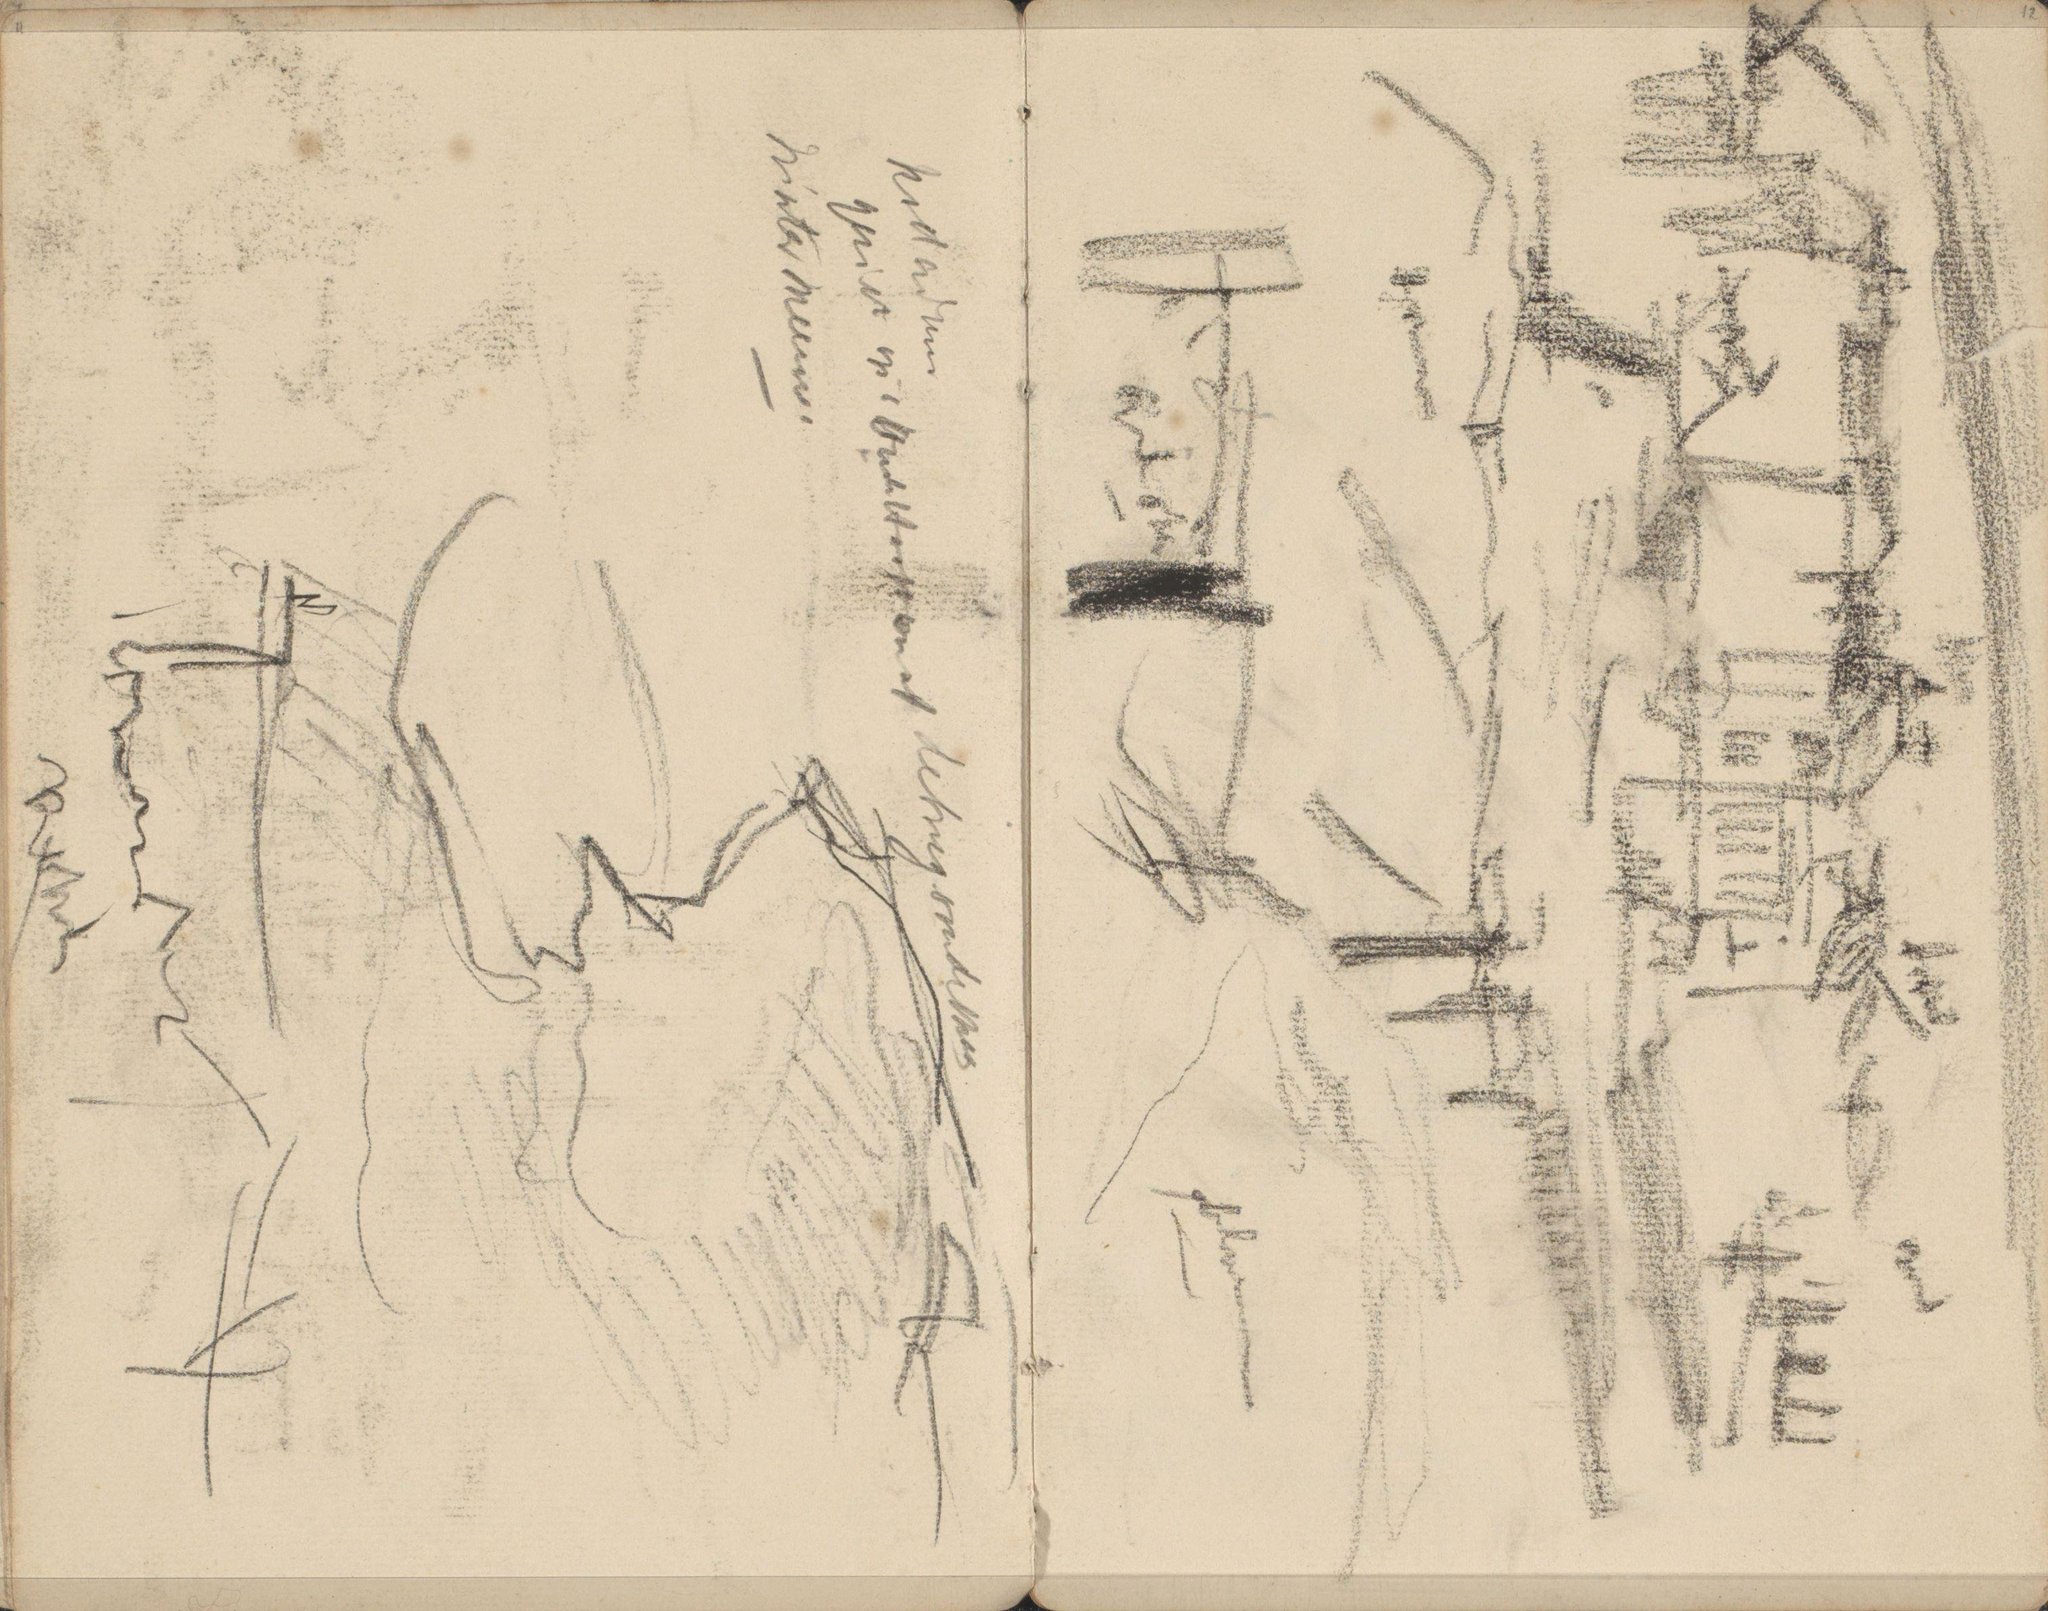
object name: sketchbook leaf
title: Gezicht op de Oude Haven te Rotterdam, gezien vanaf een brug over de Maas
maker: george hendrik breitner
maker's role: draughtsman, painter, print maker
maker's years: 1857-1923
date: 1884-1886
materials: chalk, paper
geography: rotterdam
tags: harbour, river, architecture, rotterdam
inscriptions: annotation: ‘Rotterdam/ gezicht op 't Oude Hooft vanaf de brug over de Maas/ winter sneeuw’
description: Mogelijk het station Rotterdam Maas ter vervanging van de Oude Hoofdpoort. Verder een wolkenlucht. Pagina 11 en pagina 12 uit een schetsboek met 16 bladen.